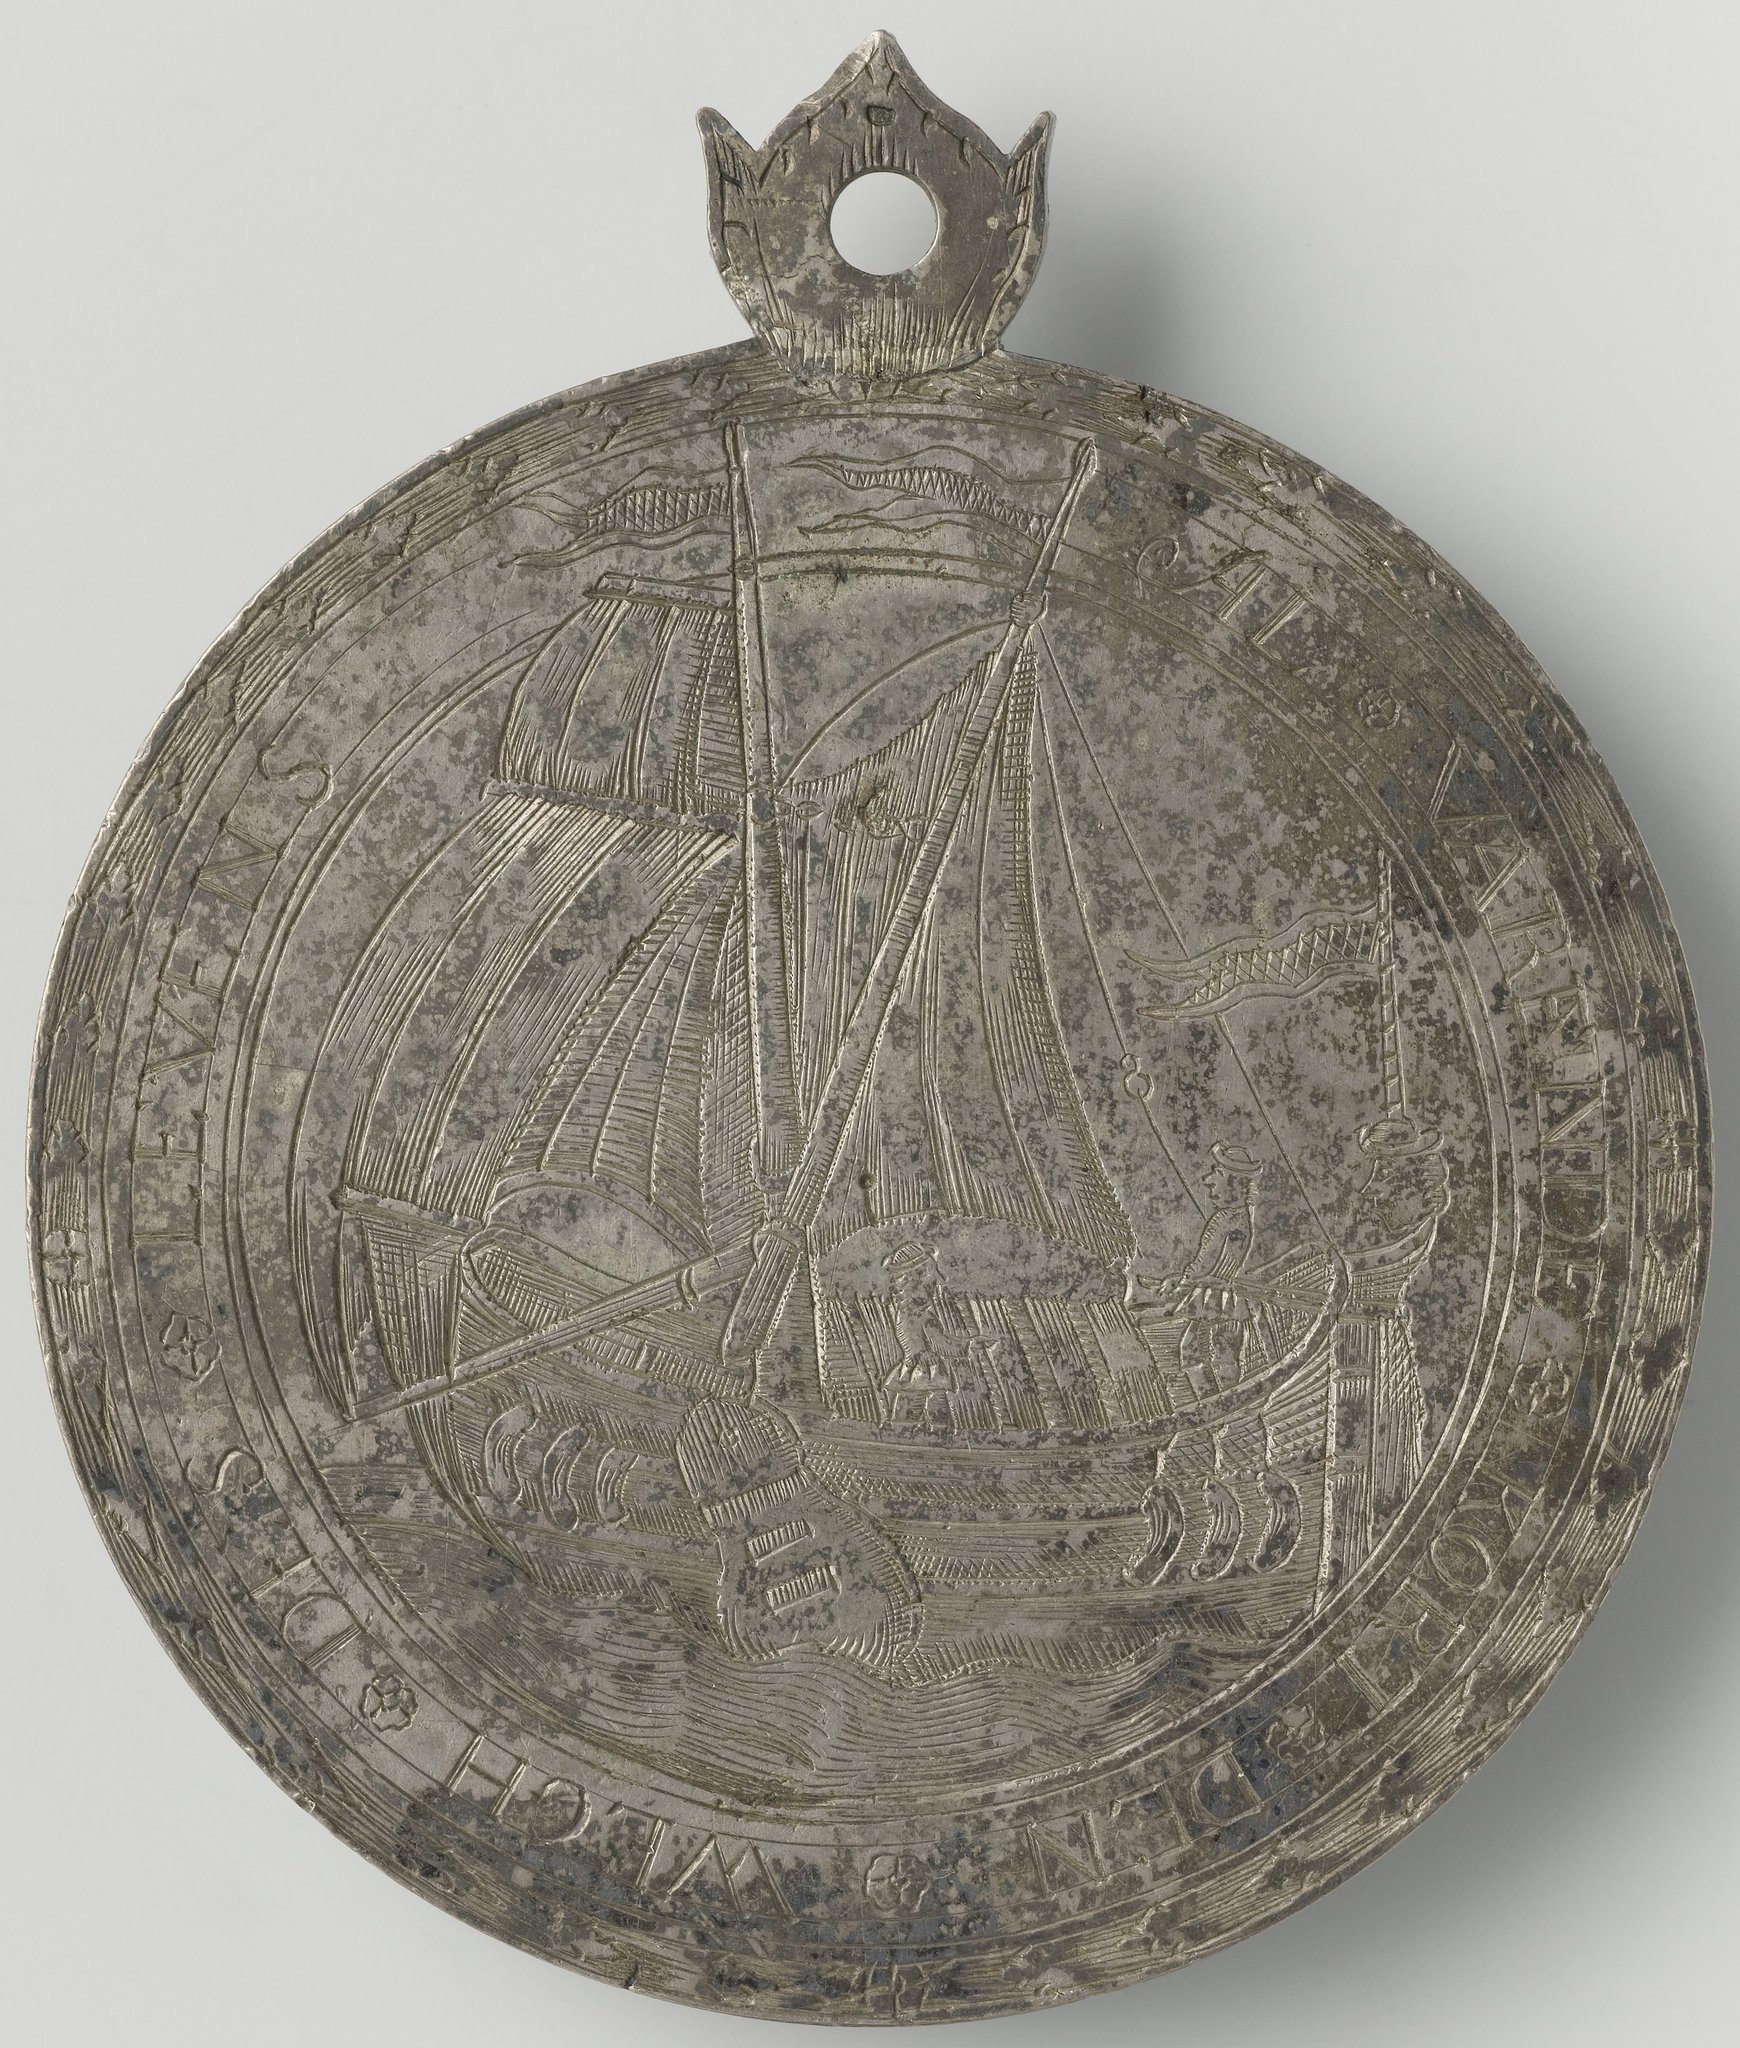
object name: medal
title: Schippersgilde te 's-Hertogenbosch, gildepenning door het gilde geschonken aan opperdeken Willem Cornelis Ackerdyck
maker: Anonymous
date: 1750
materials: silver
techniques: engraving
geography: den bosch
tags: den bosch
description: Zilveren penning aan draagoog in vorm van bloem met drie bladeren. Voorzijde: naar links varende tjalk met tweekoppige bemanning binnen omschrift en bladerkrans. Keerzijde: gekroond wapenschild, geflankeerd door twee halfnaakte mannen met knots over schouder; daaronder siermotief binnen omschrift en bladerkrans